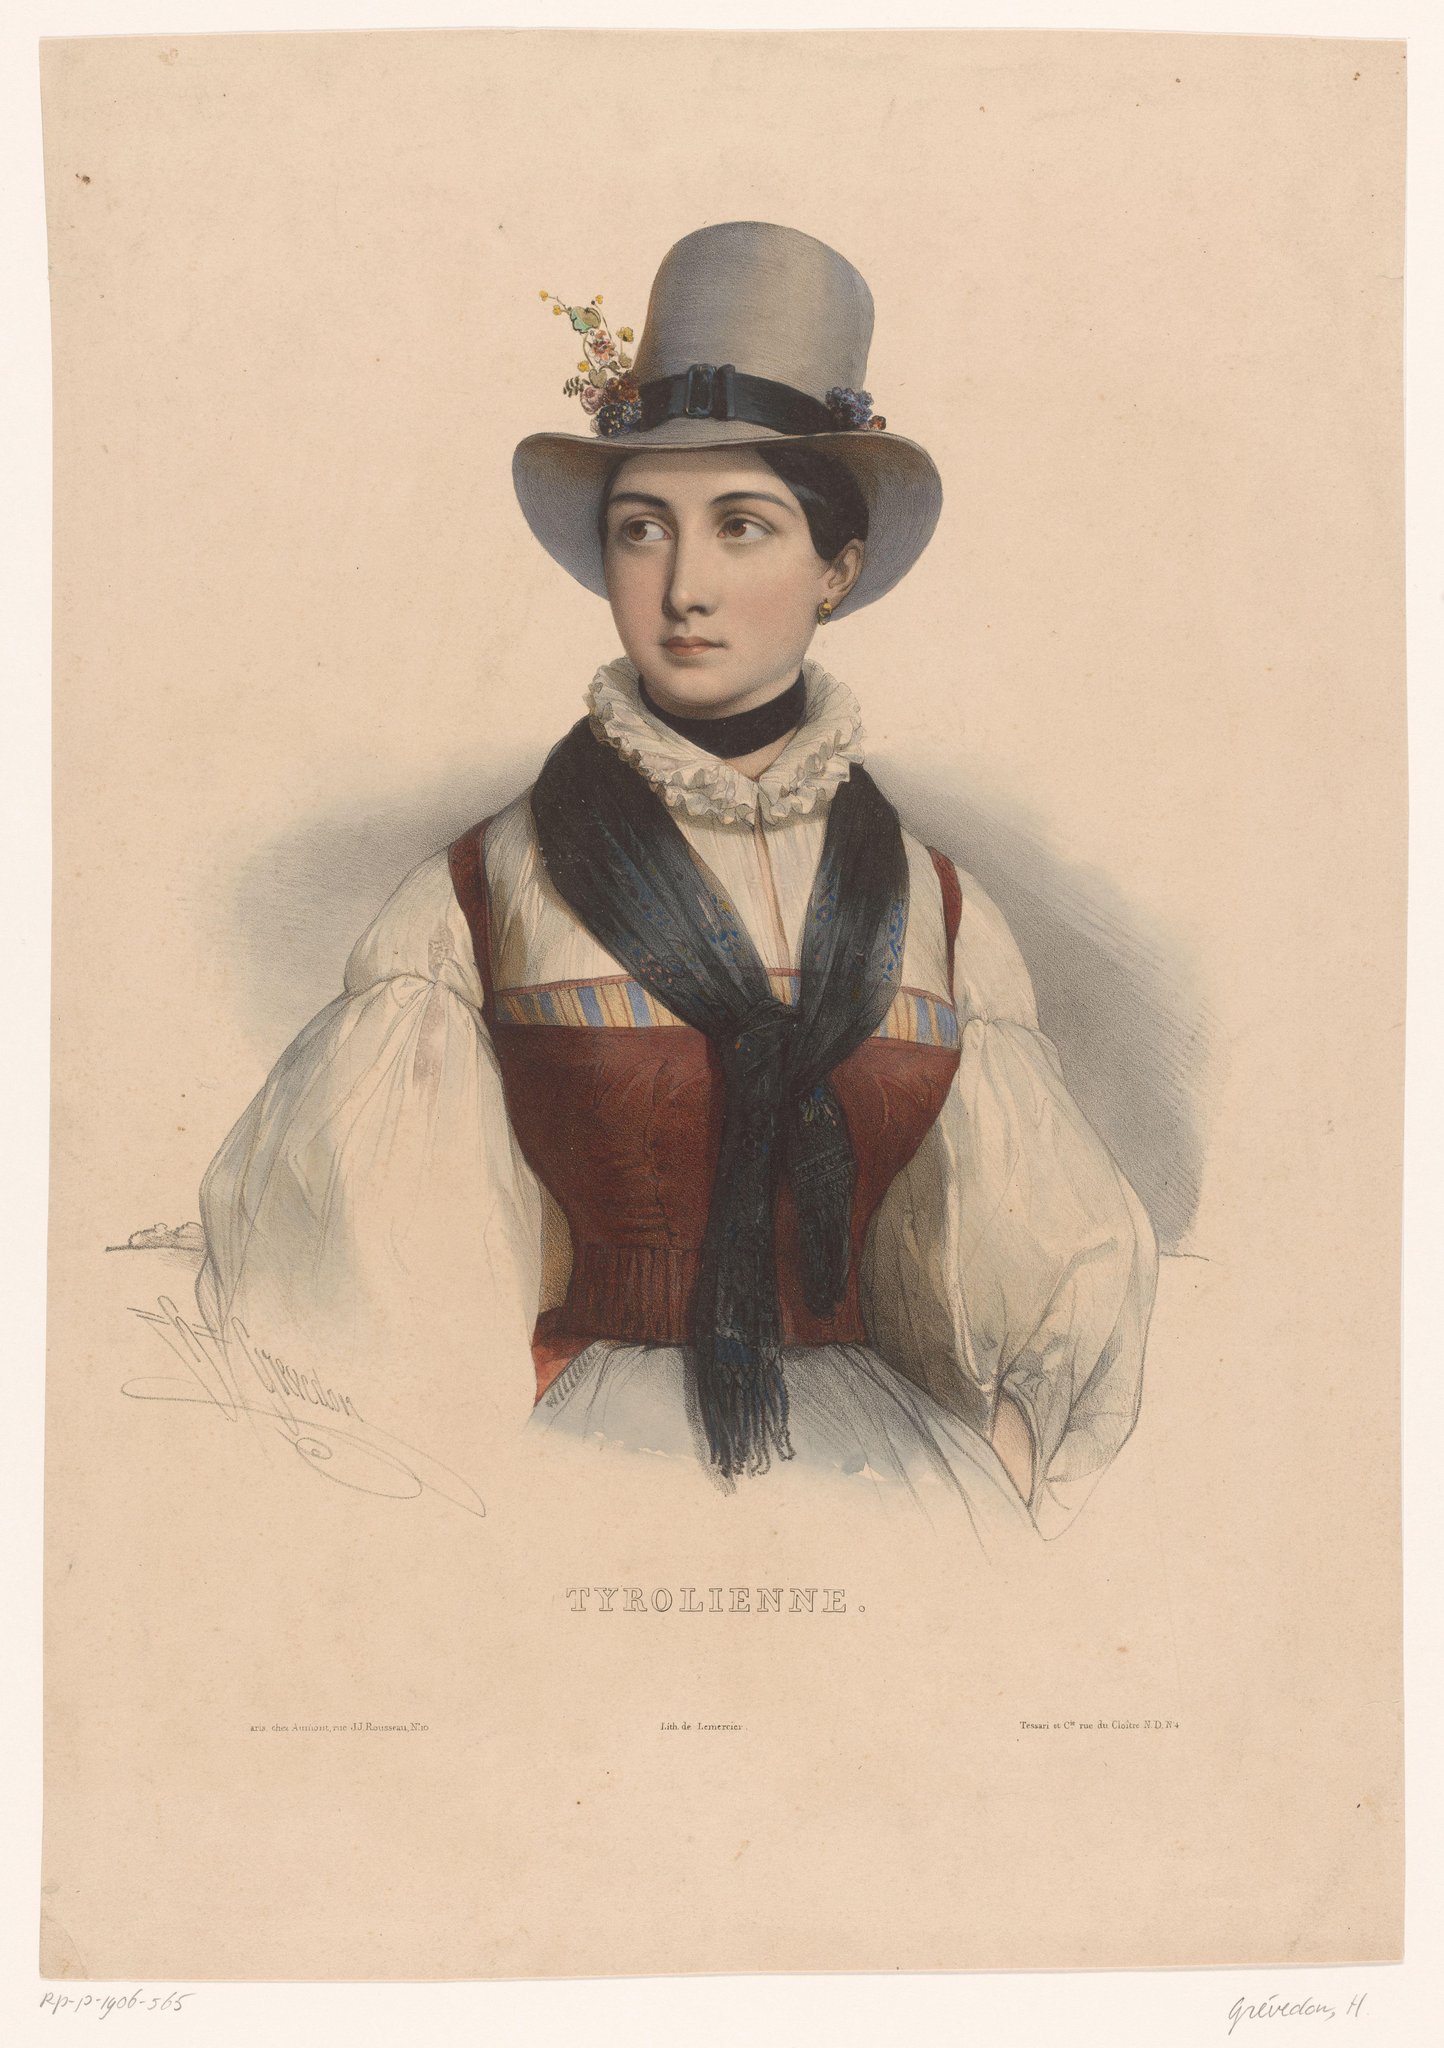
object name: print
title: Vrouwen in klederdracht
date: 1835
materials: paper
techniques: hand coloring, lithograph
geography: paris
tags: human types, folk costume, regional costume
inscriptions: collector's mark: Lugt 2228a